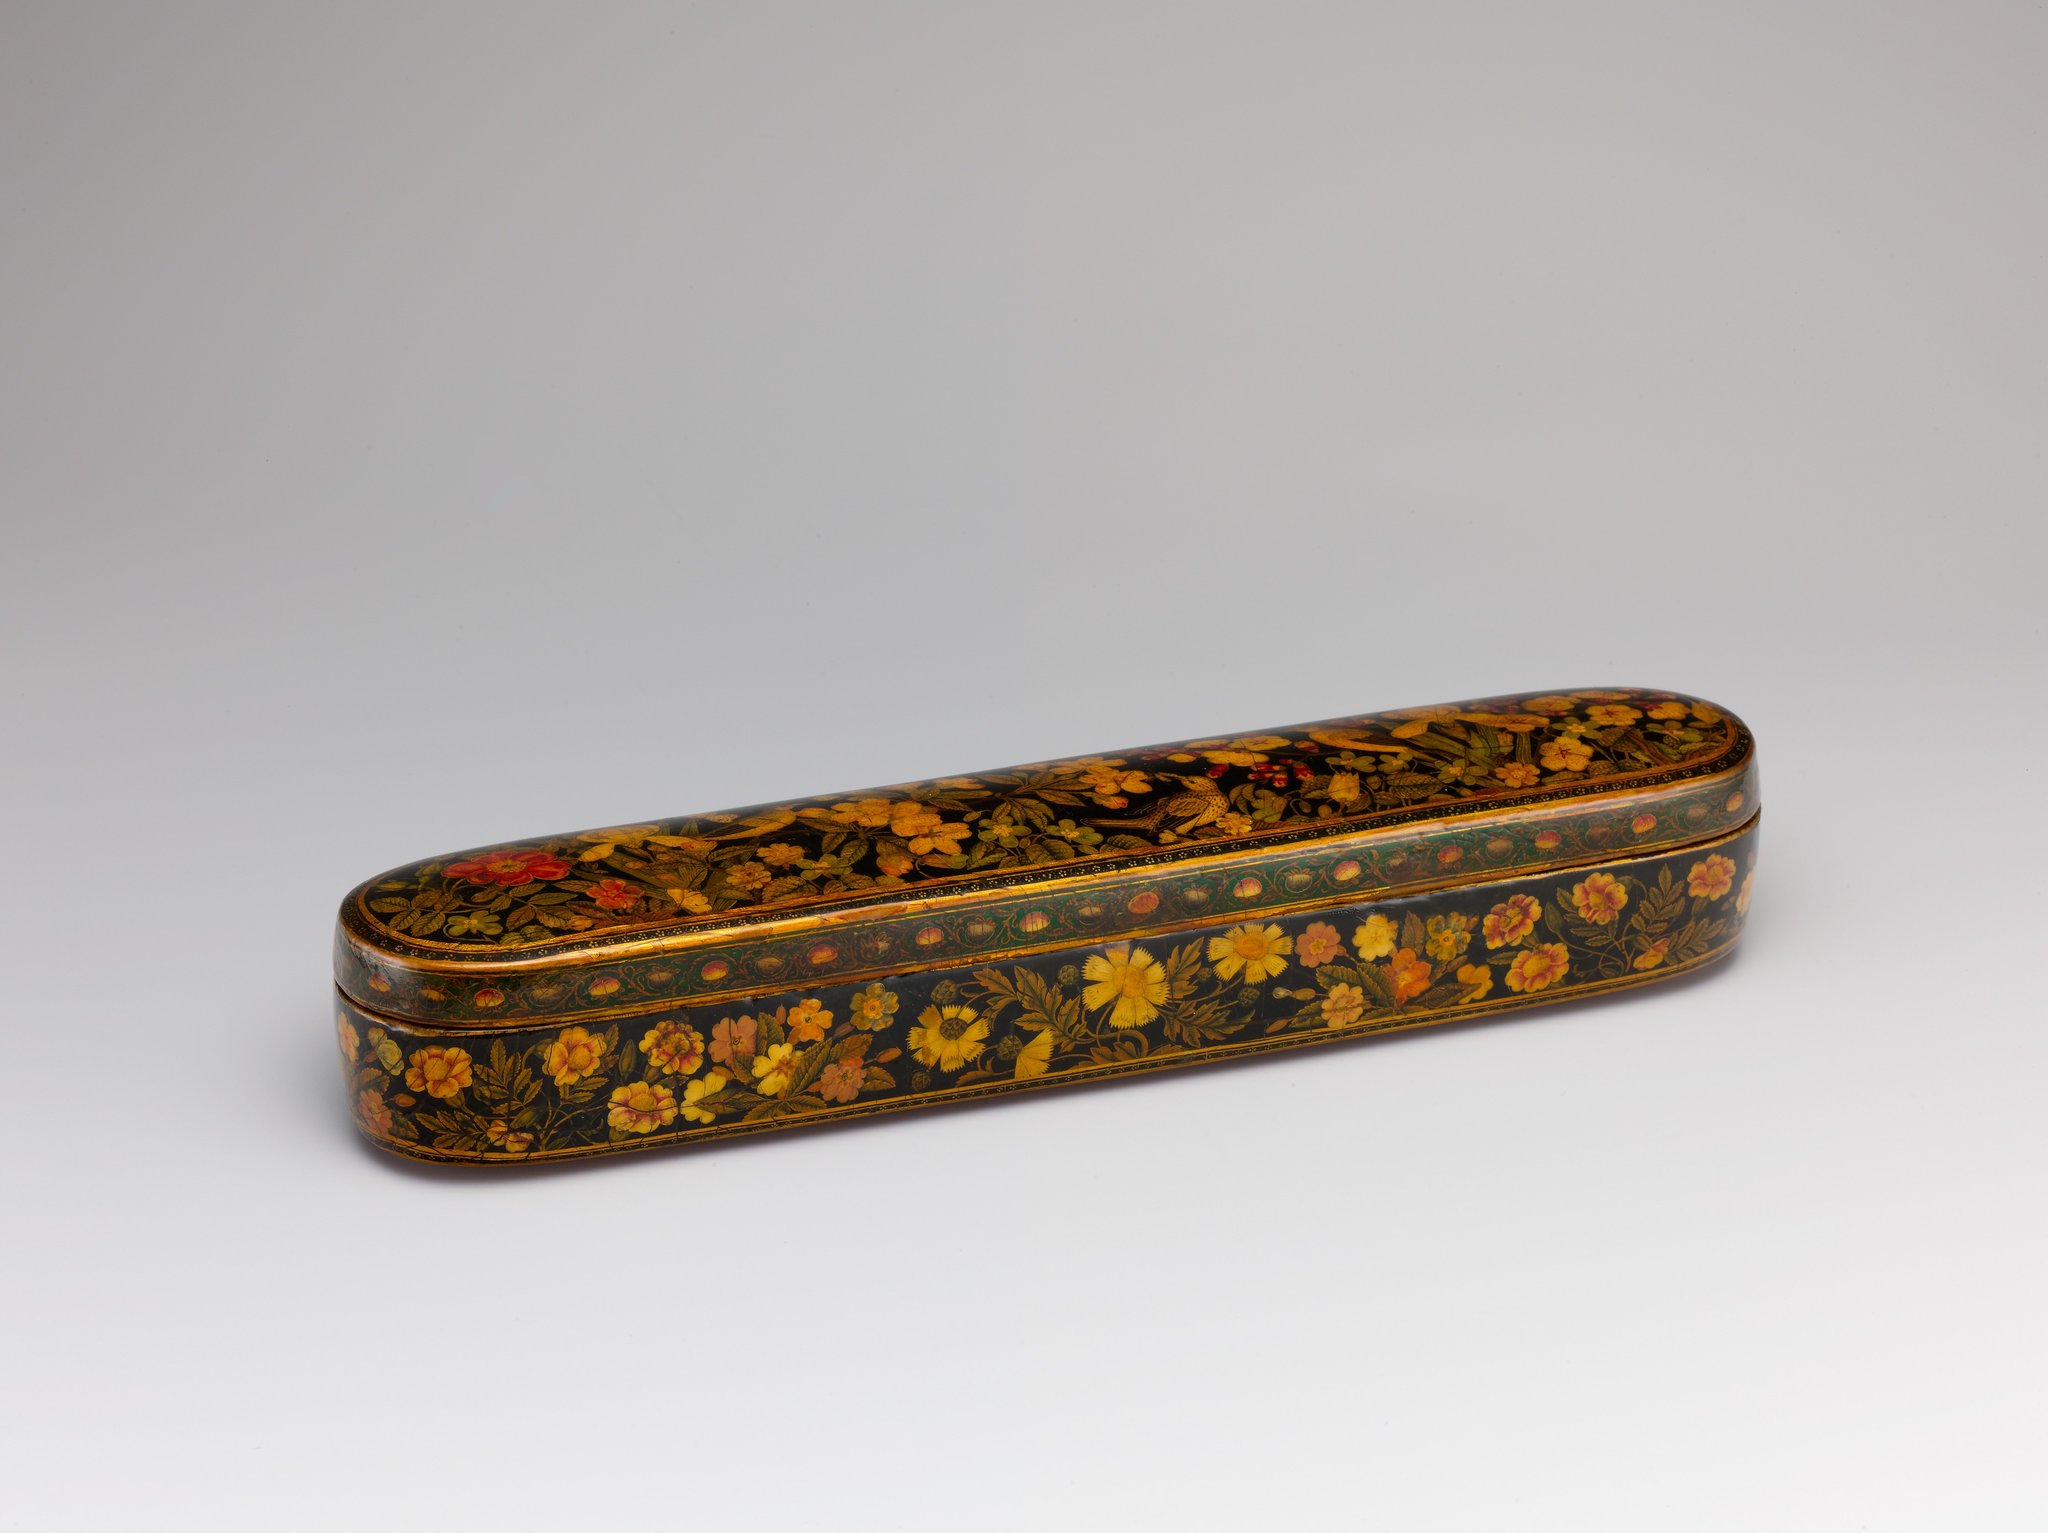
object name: pen box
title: Pen Box with a Europeanizing Landscape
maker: haji muhammad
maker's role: artist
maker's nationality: iranian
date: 1667-1733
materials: paper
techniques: lacquer, painting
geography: iran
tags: flowers